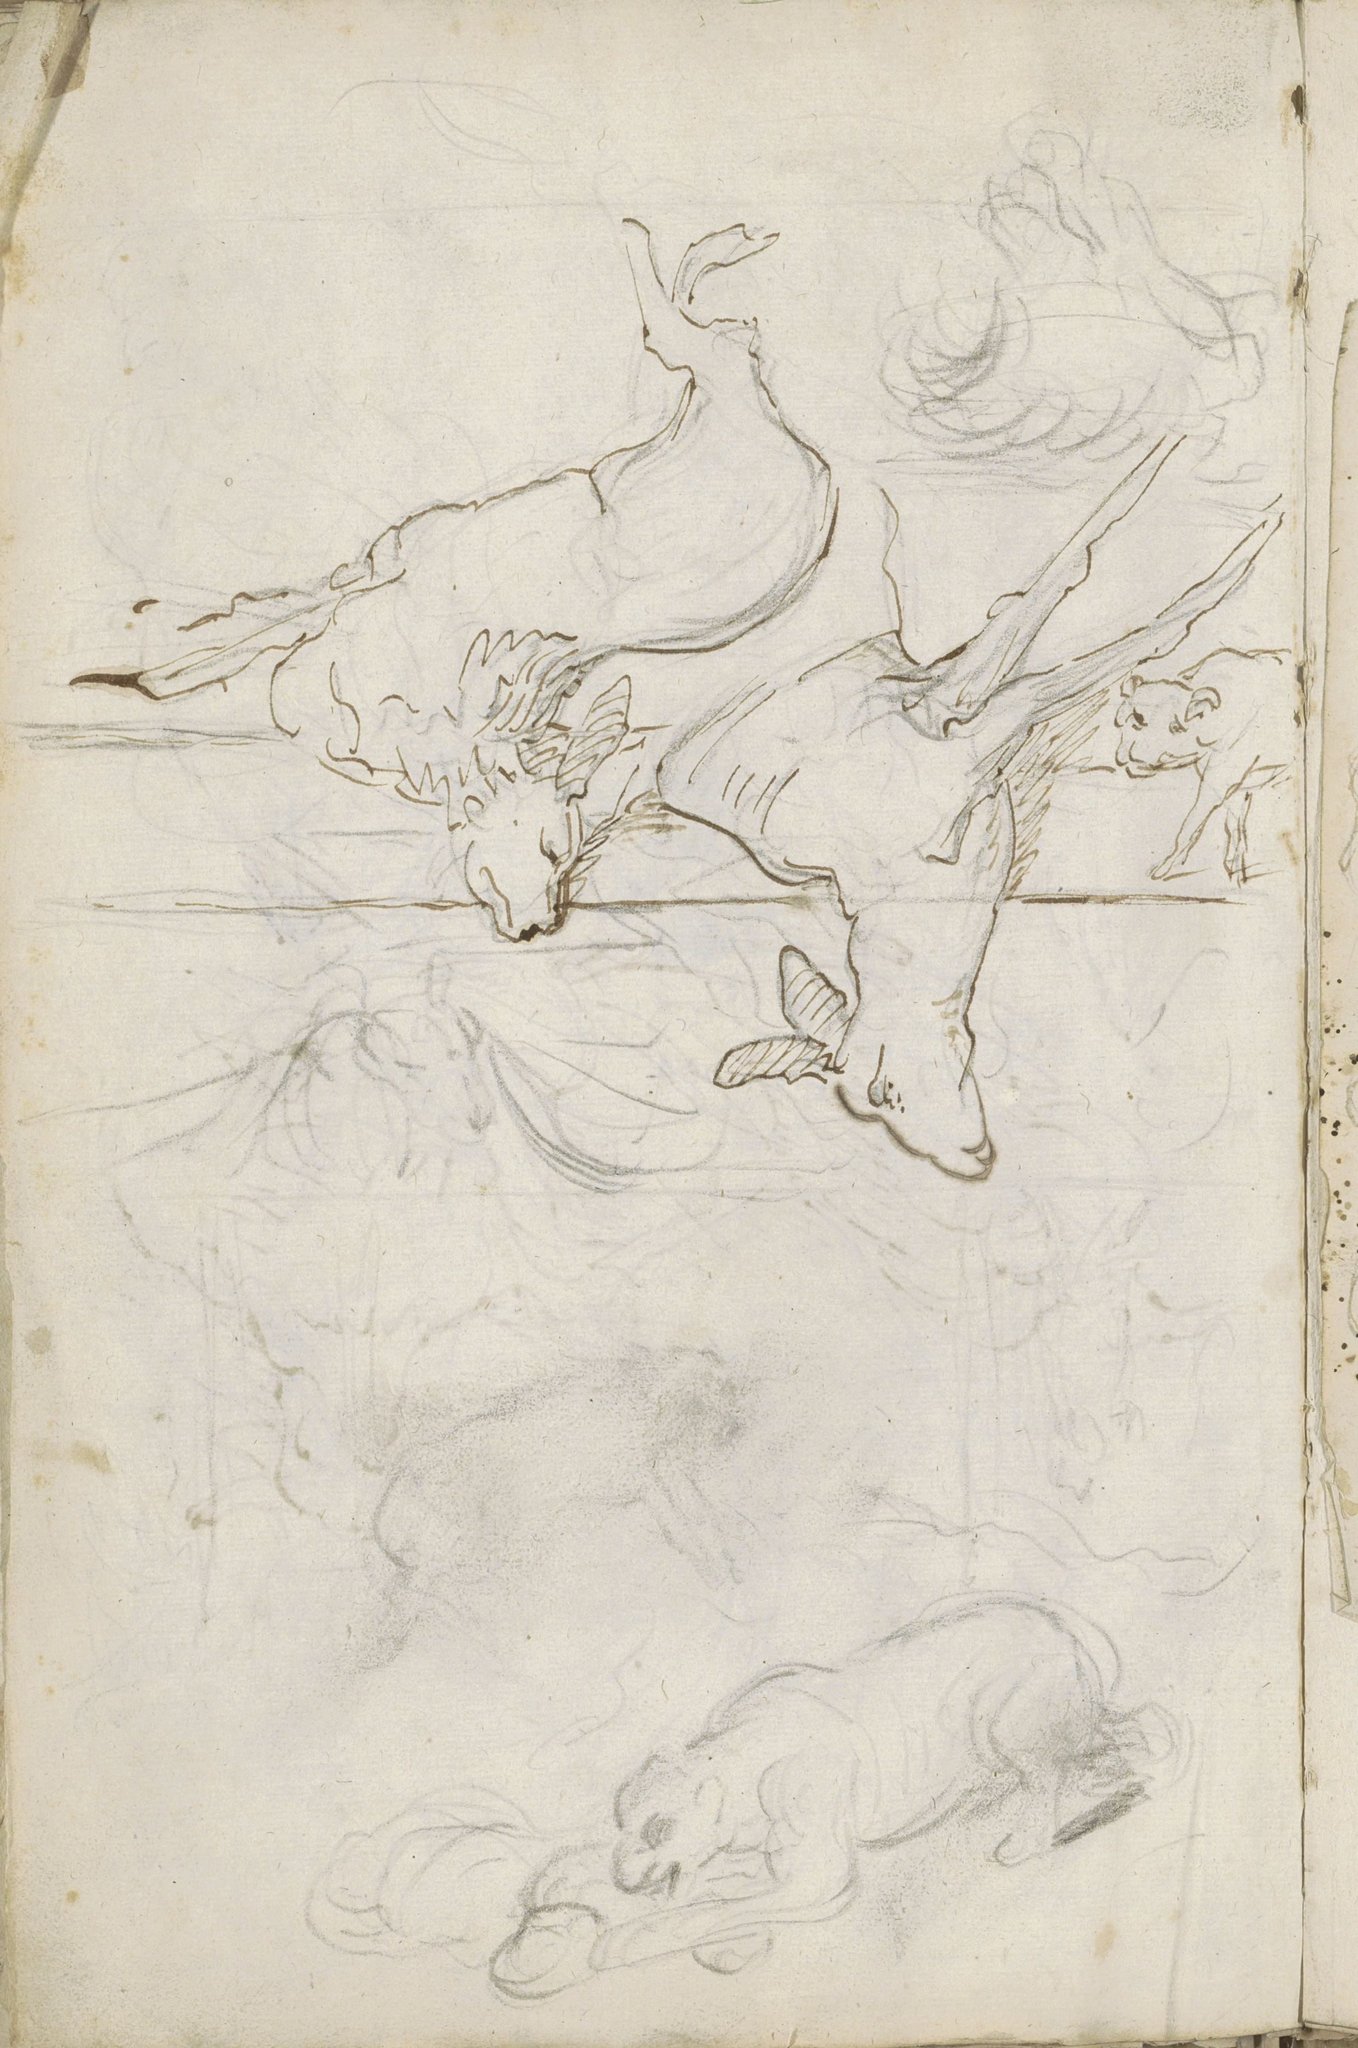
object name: sketchbook leaf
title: Dode herten op een plint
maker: paul de vos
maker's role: draughtsman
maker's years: 1595-1678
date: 1605-1678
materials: chalk, ink, paper, pencil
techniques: pen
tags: hoofed animals: deer (+ animal killed by man)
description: Tevens studies van dieren. Blad 10 verso uit een schetsboek met 15 bladen.